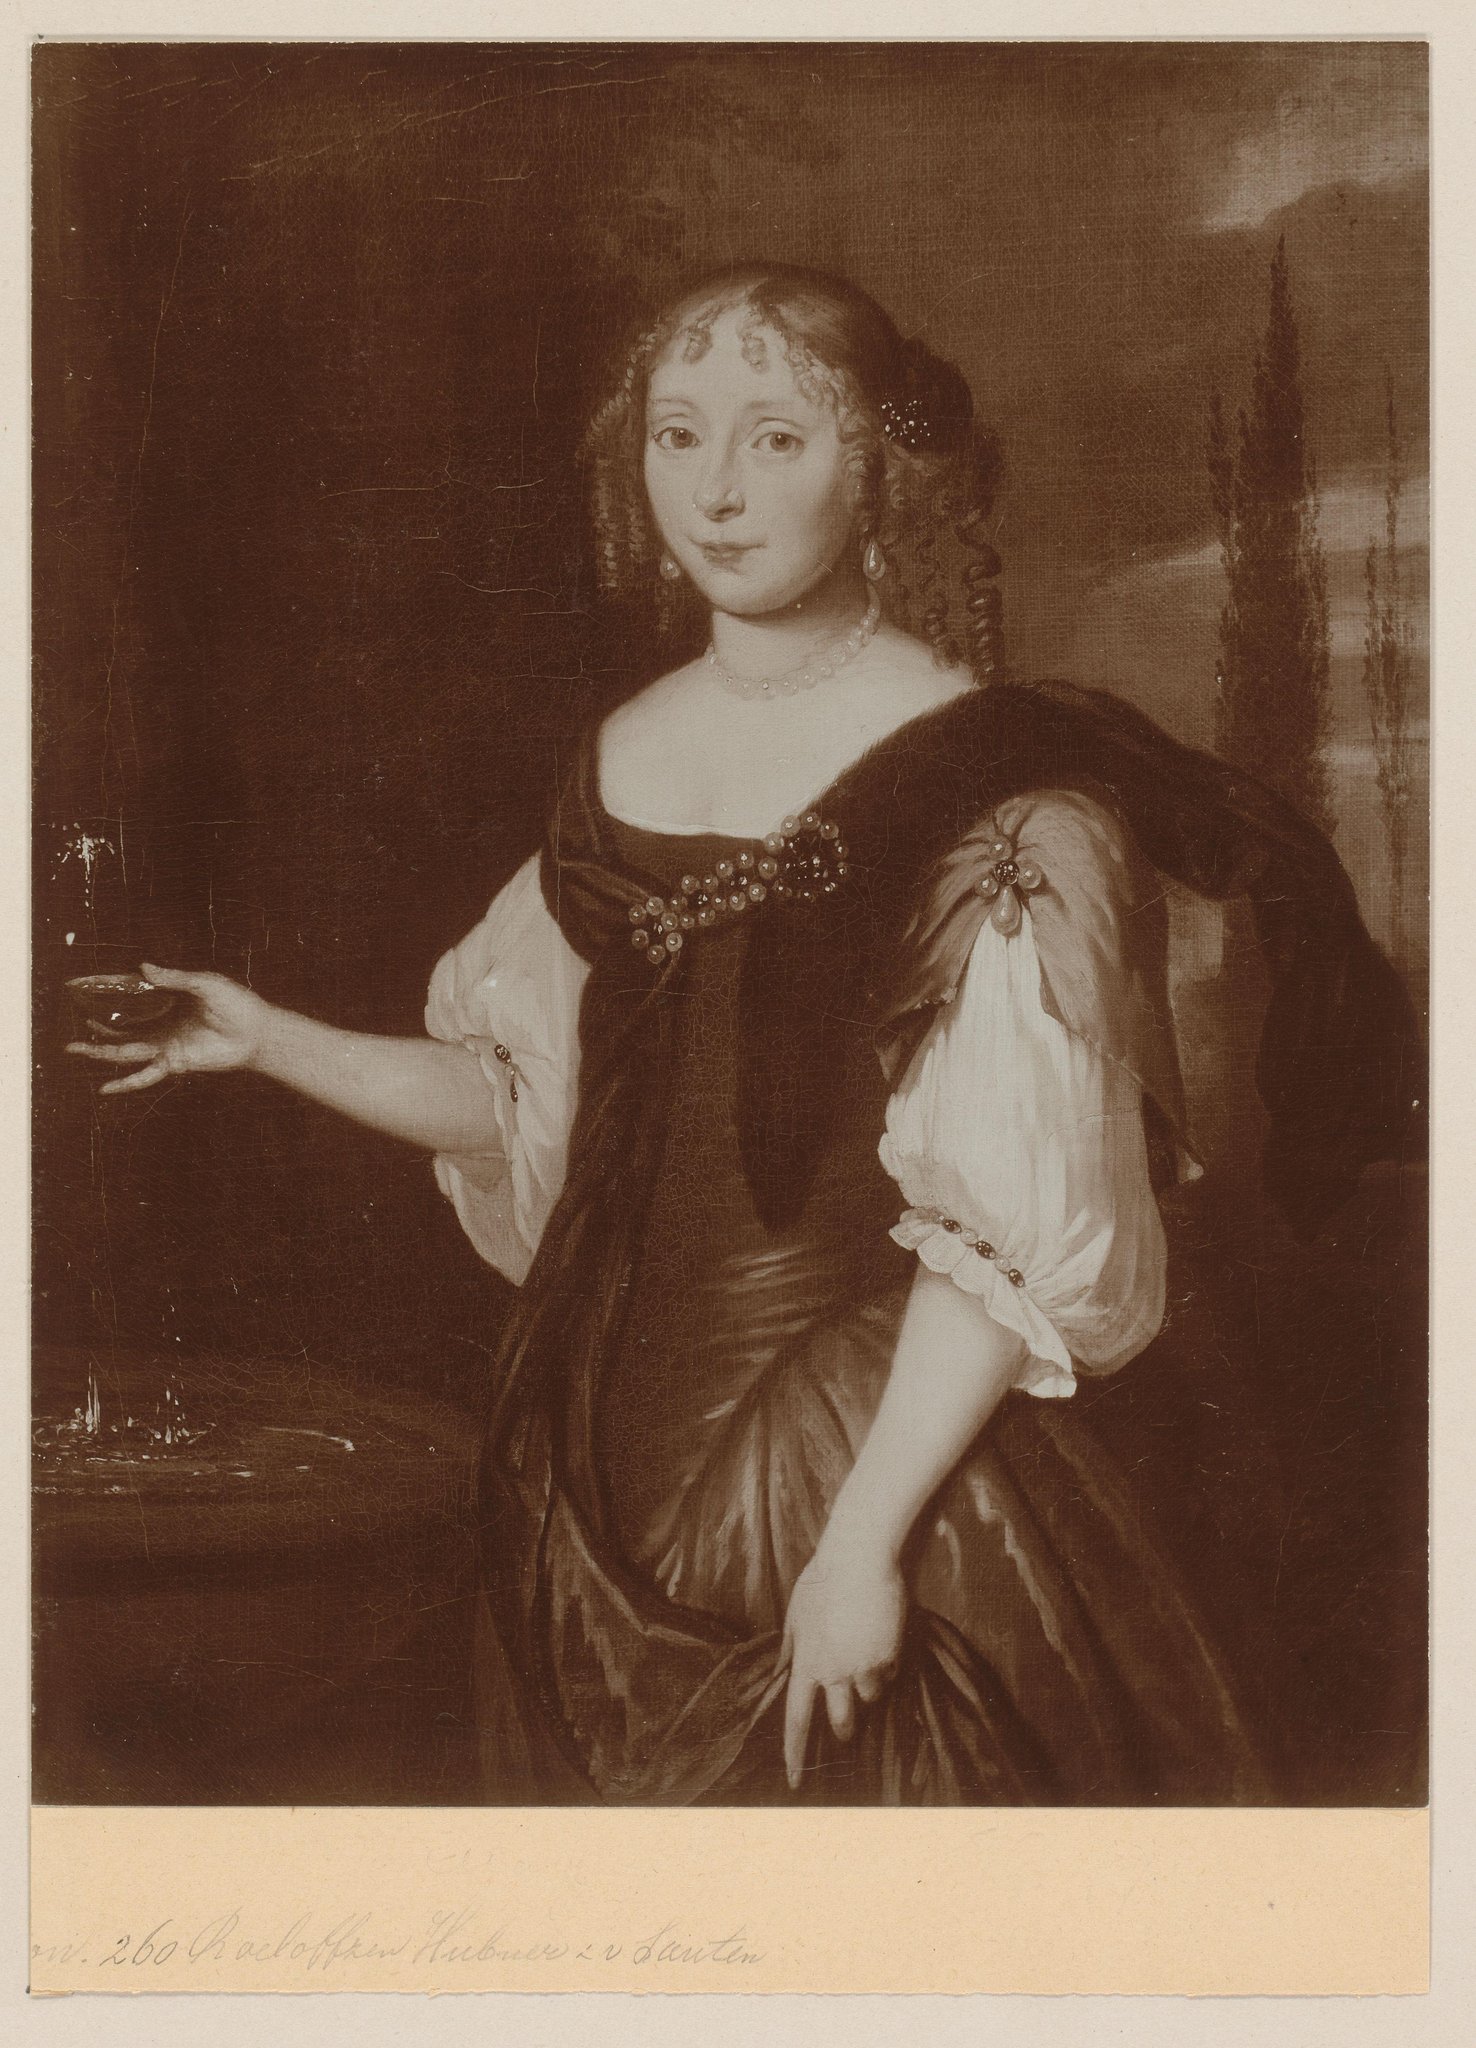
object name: reproduction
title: Fotoreproductie van een geschilderd portret van Margaretha Le Gouche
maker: Anonymous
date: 1885-1920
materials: cardboard, paper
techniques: collodion silver print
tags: historical persons - bb - woman, picture, painting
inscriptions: collector's mark: Lugt 2228a, number: ‘[...]w. 260’